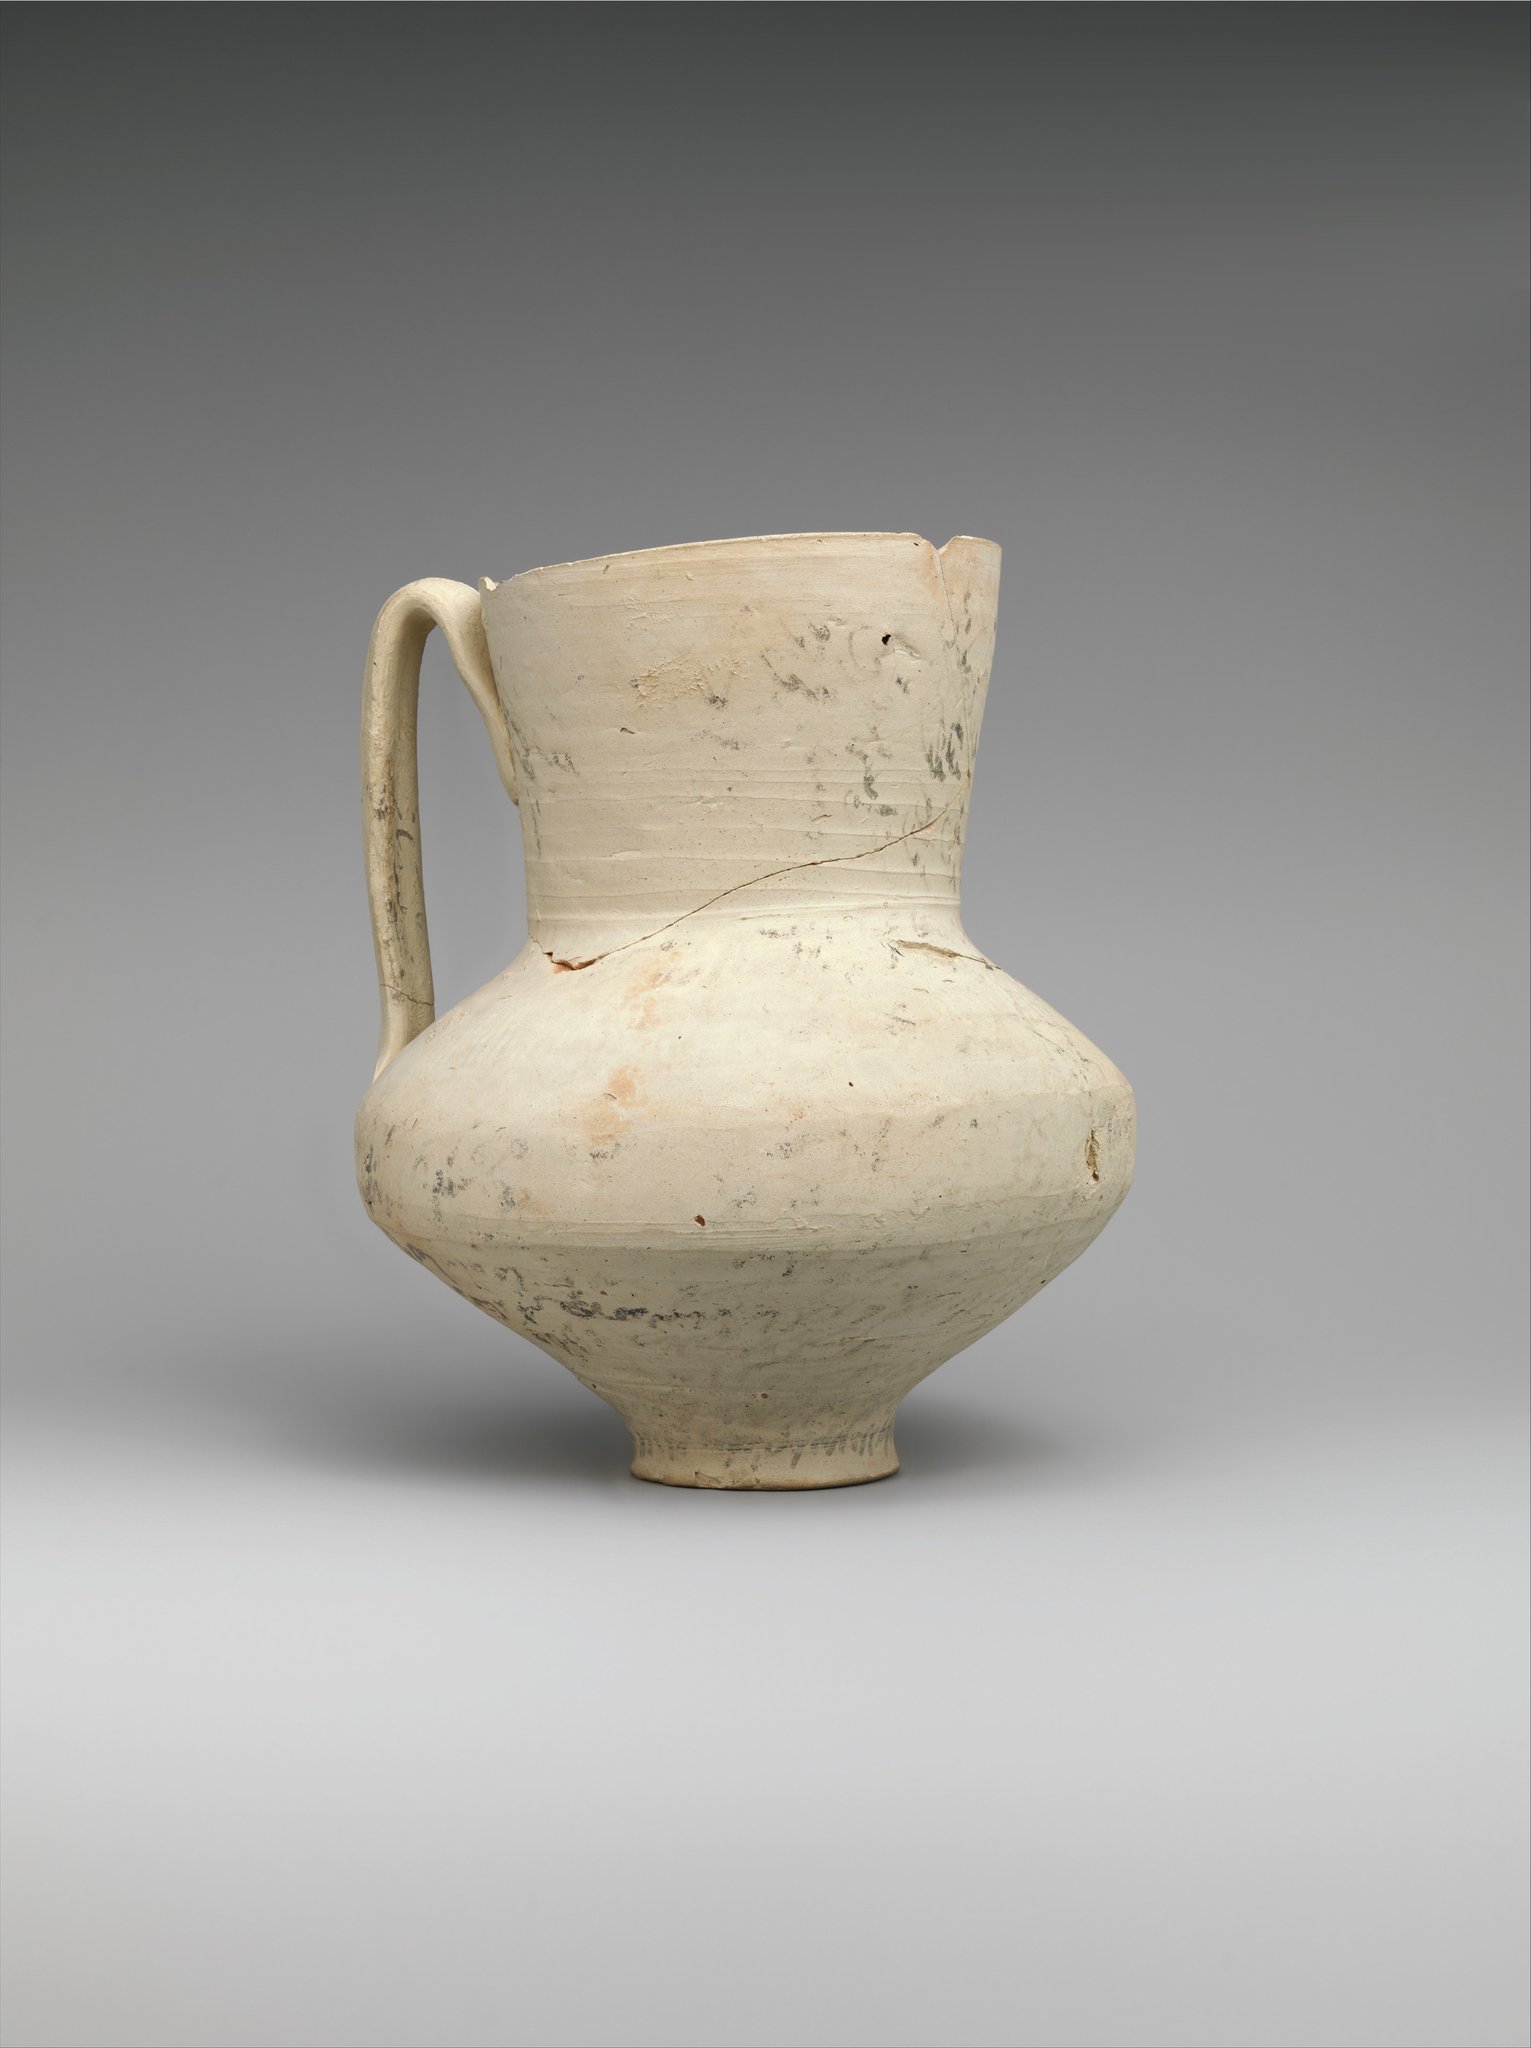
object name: ewer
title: Unglazed Jug with Writing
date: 701-900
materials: earthenware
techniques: painting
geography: iran